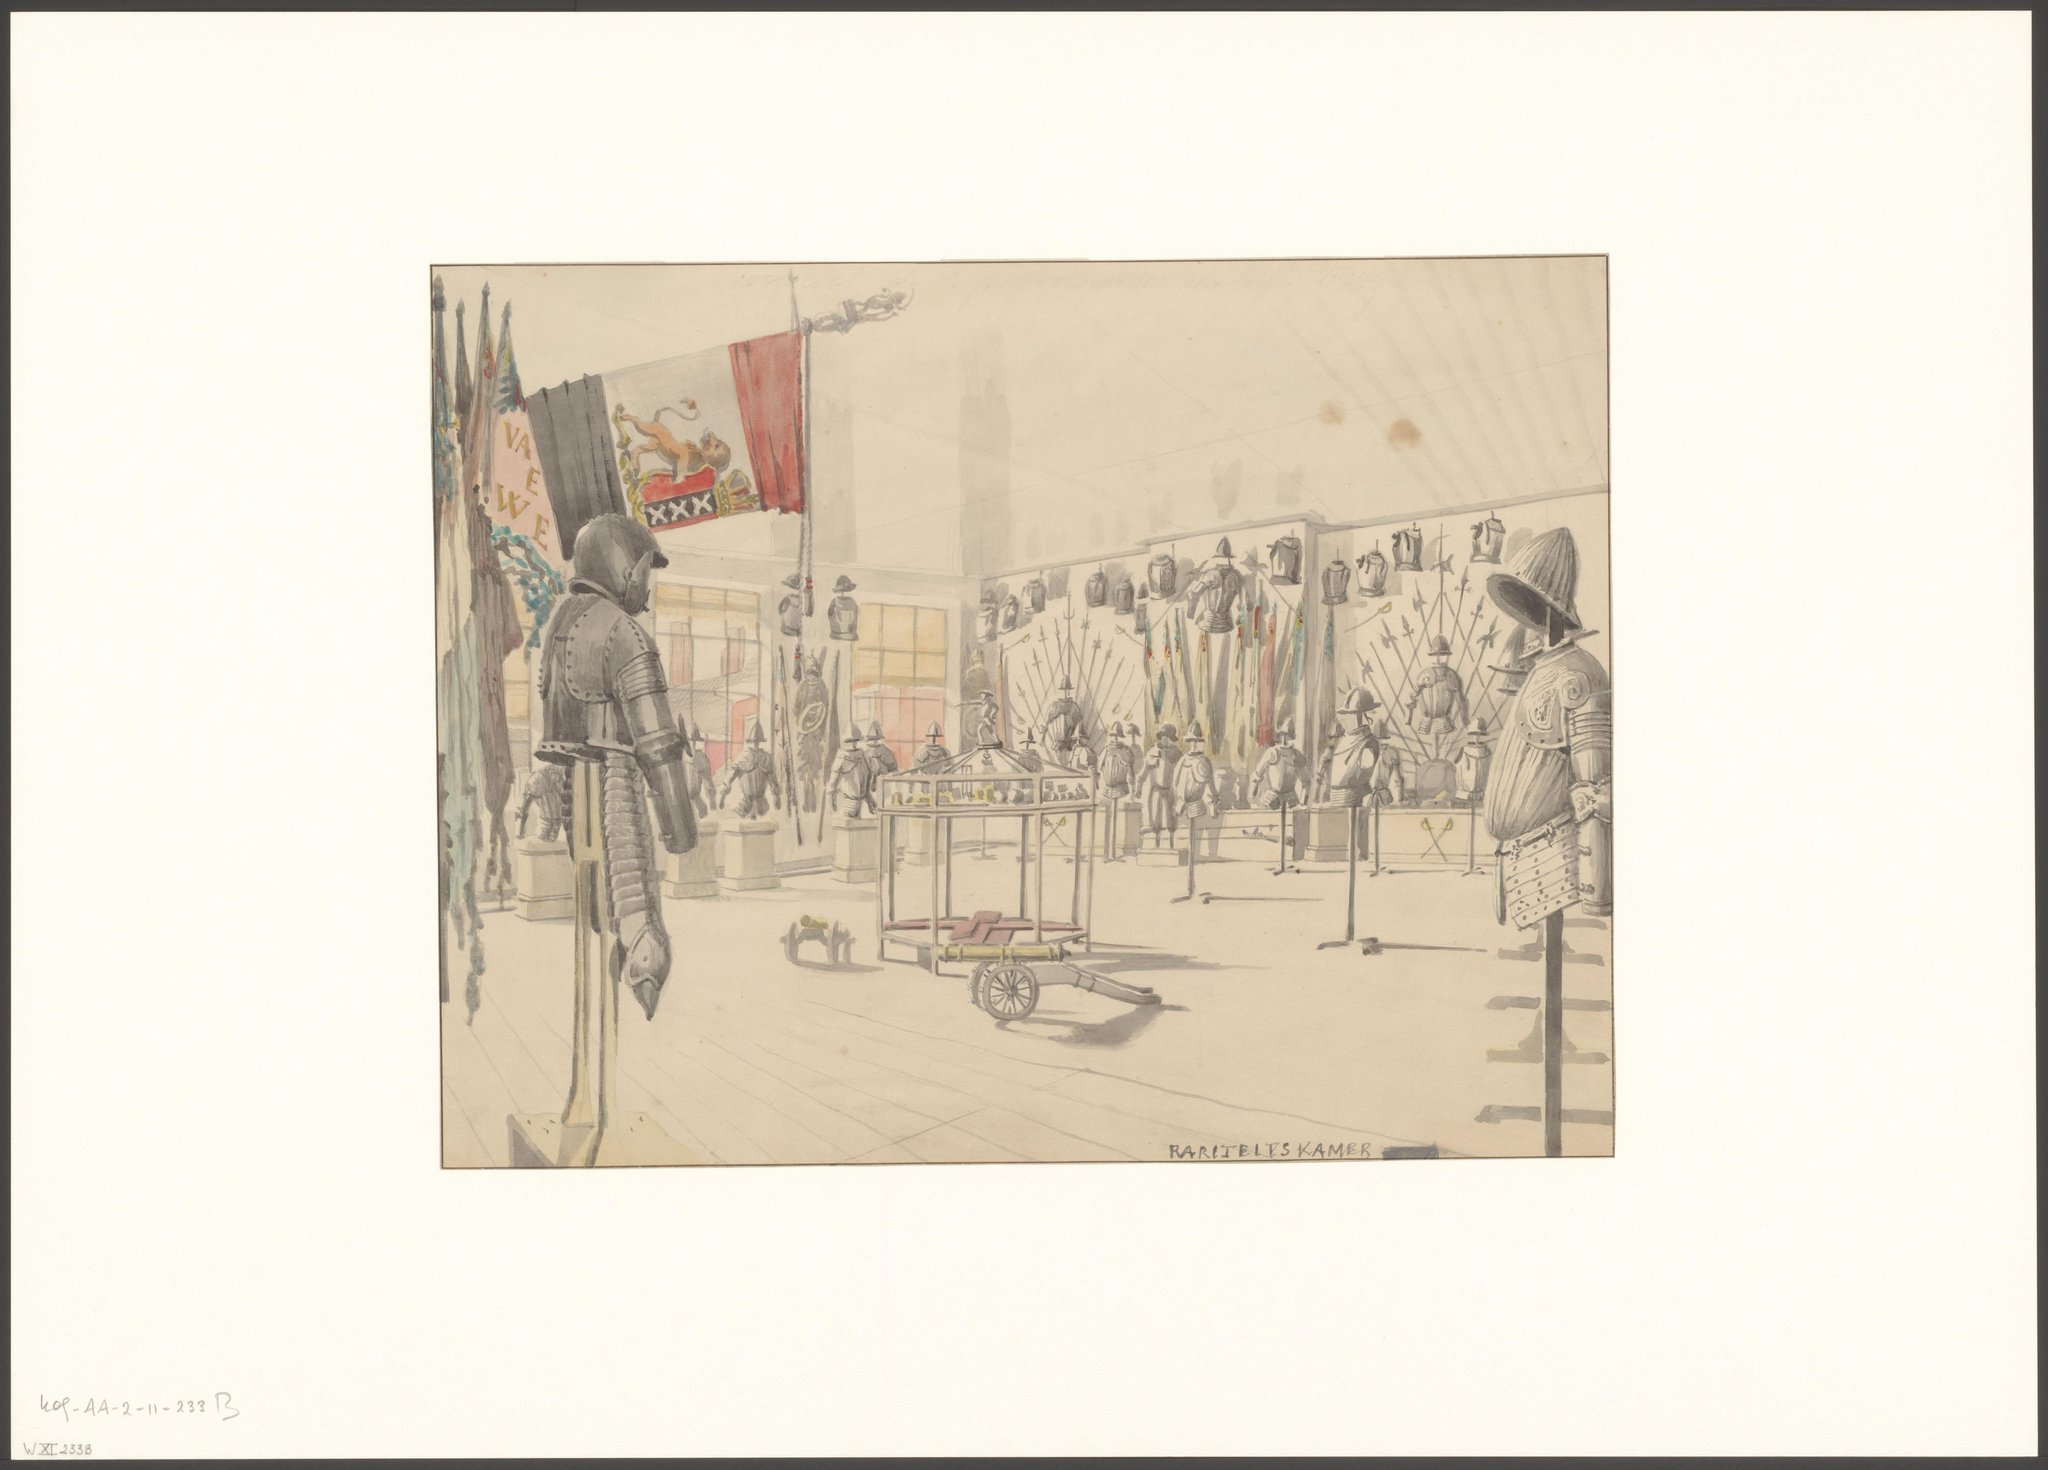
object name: drawing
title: Interieur van de rariteitenkamer van het stadhuis aan het Prinsenhof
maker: johan george lodewijk rieke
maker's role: draughtsman, print maker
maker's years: 1817-1898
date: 1827-1898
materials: paper, pencil, watercolor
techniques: brush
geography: amsterdam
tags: townhall, cabinet of curiosities, 'kunst- und wunderkammer'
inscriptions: inscription: ‘rariteitskamer’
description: Tekening binnen de Atlas Van Eck ingedeeld op wijknummer 11.